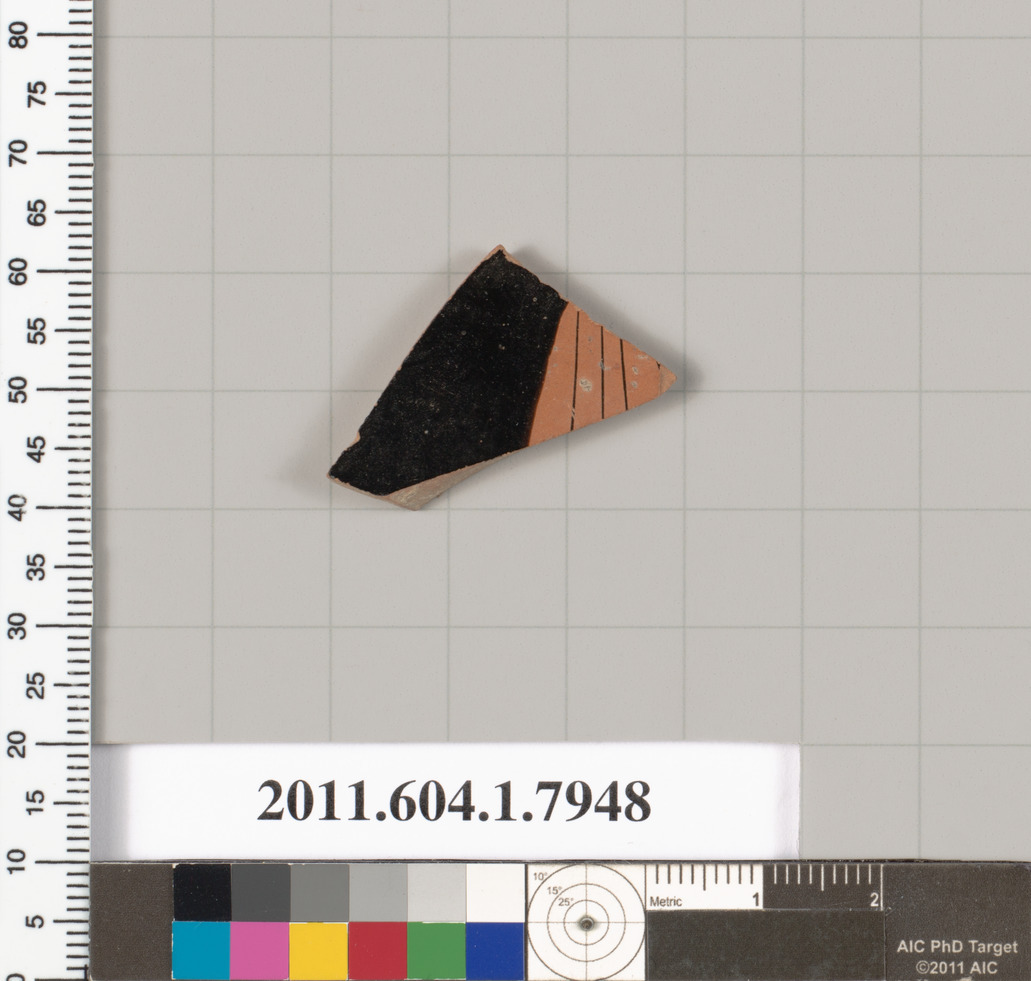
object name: kylix fragment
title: Terracotta fragment of a kylix (drinking cup)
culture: greek, attic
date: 460-450 BCE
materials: terracotta